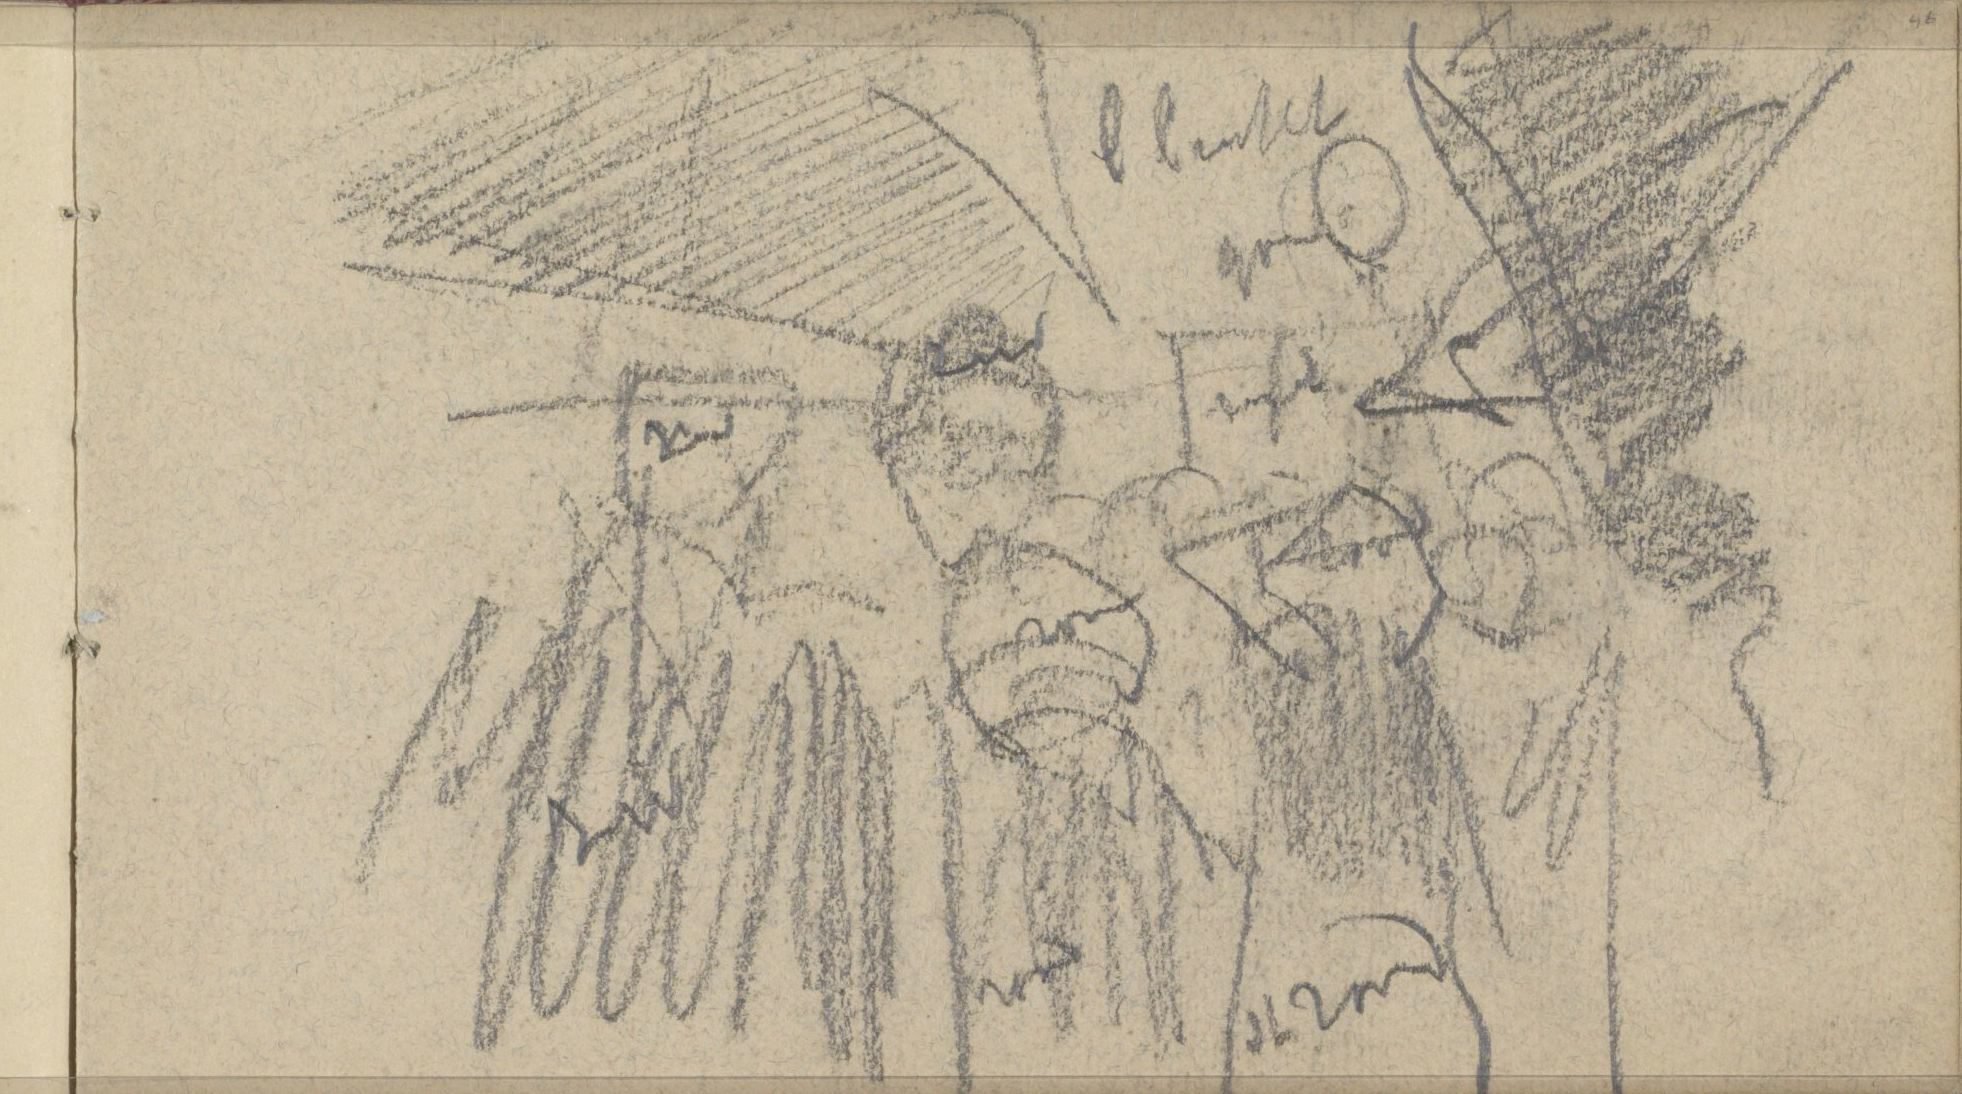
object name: sketchbook leaf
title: Groep figuren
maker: george hendrik breitner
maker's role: draughtsman, painter, print maker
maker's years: 1857-1923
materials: chalk, paper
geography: amsterdam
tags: adult woman, adult man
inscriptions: kleurnotitie, handgeschreven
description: Pagina 46 uit een schetsboek met 32 bladen.